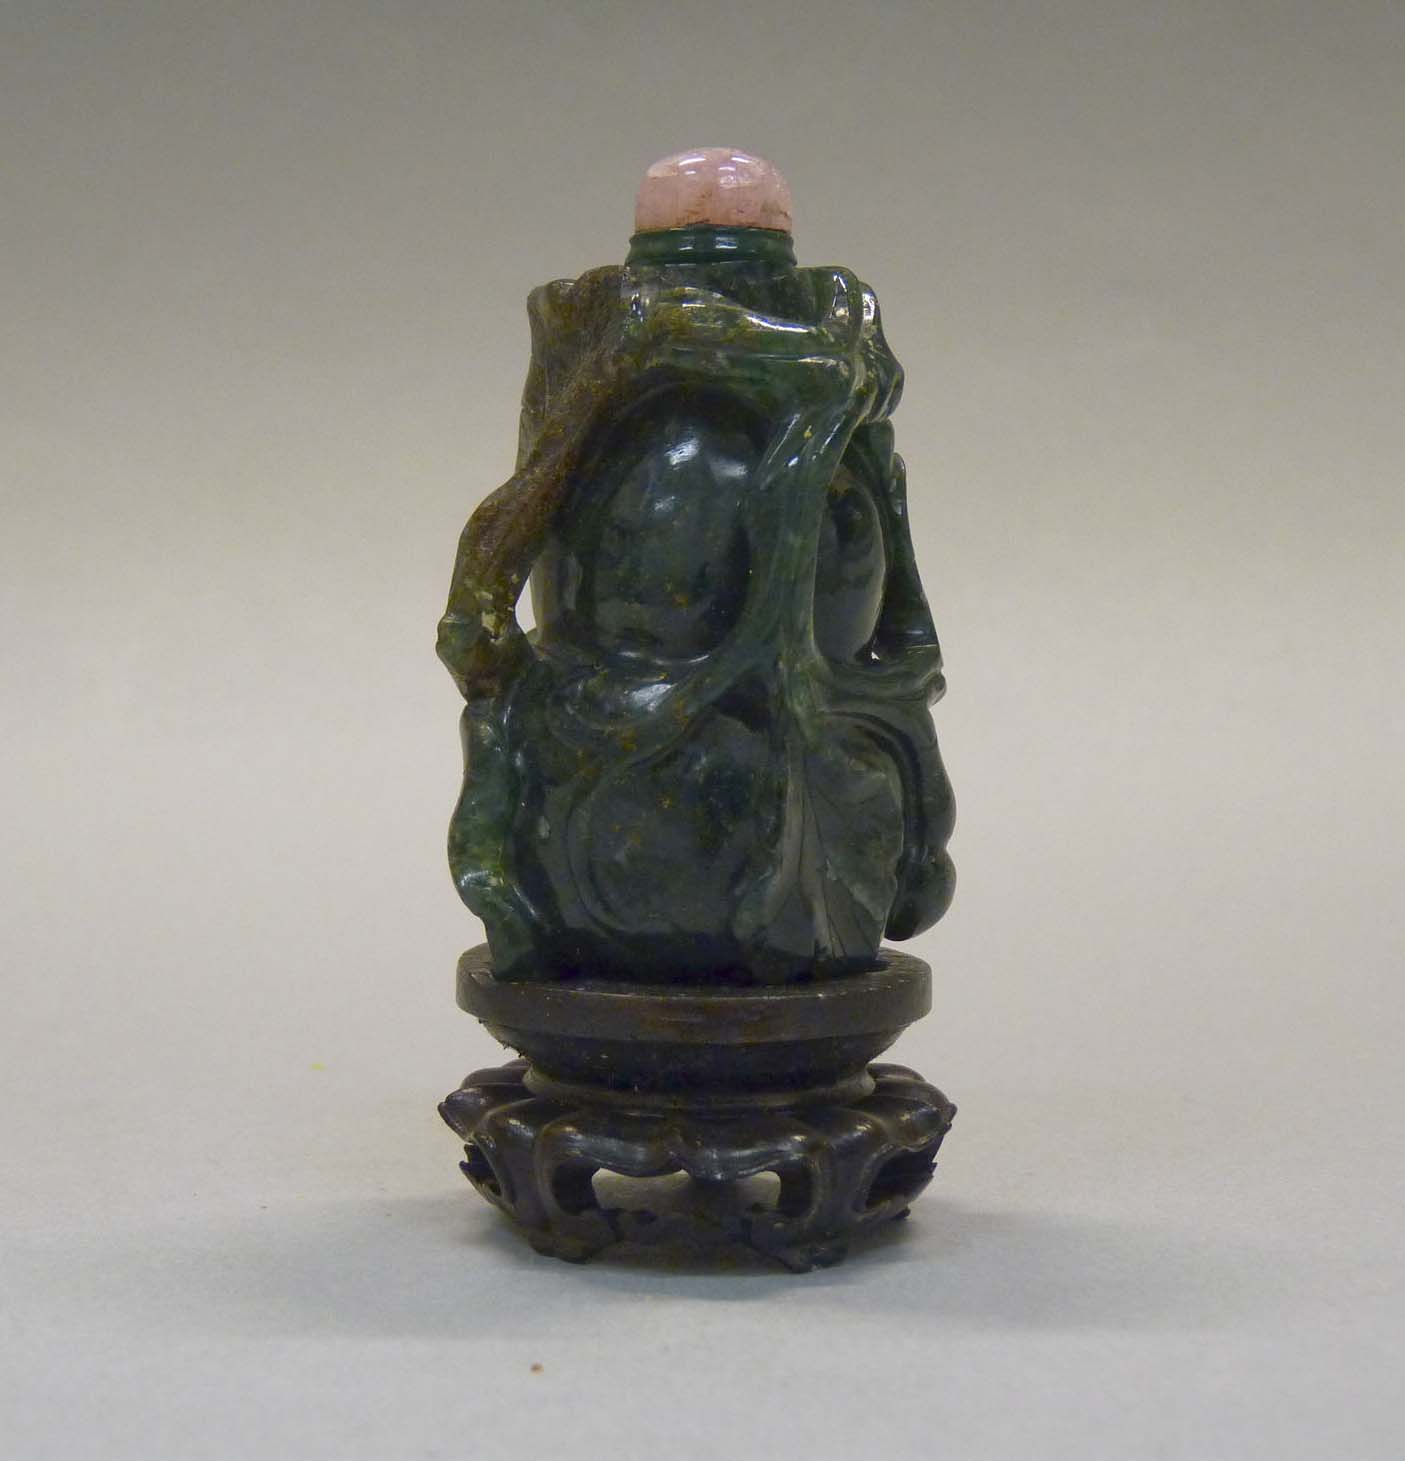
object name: snuff bottle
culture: chinese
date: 1736-1795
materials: stone, gemstone